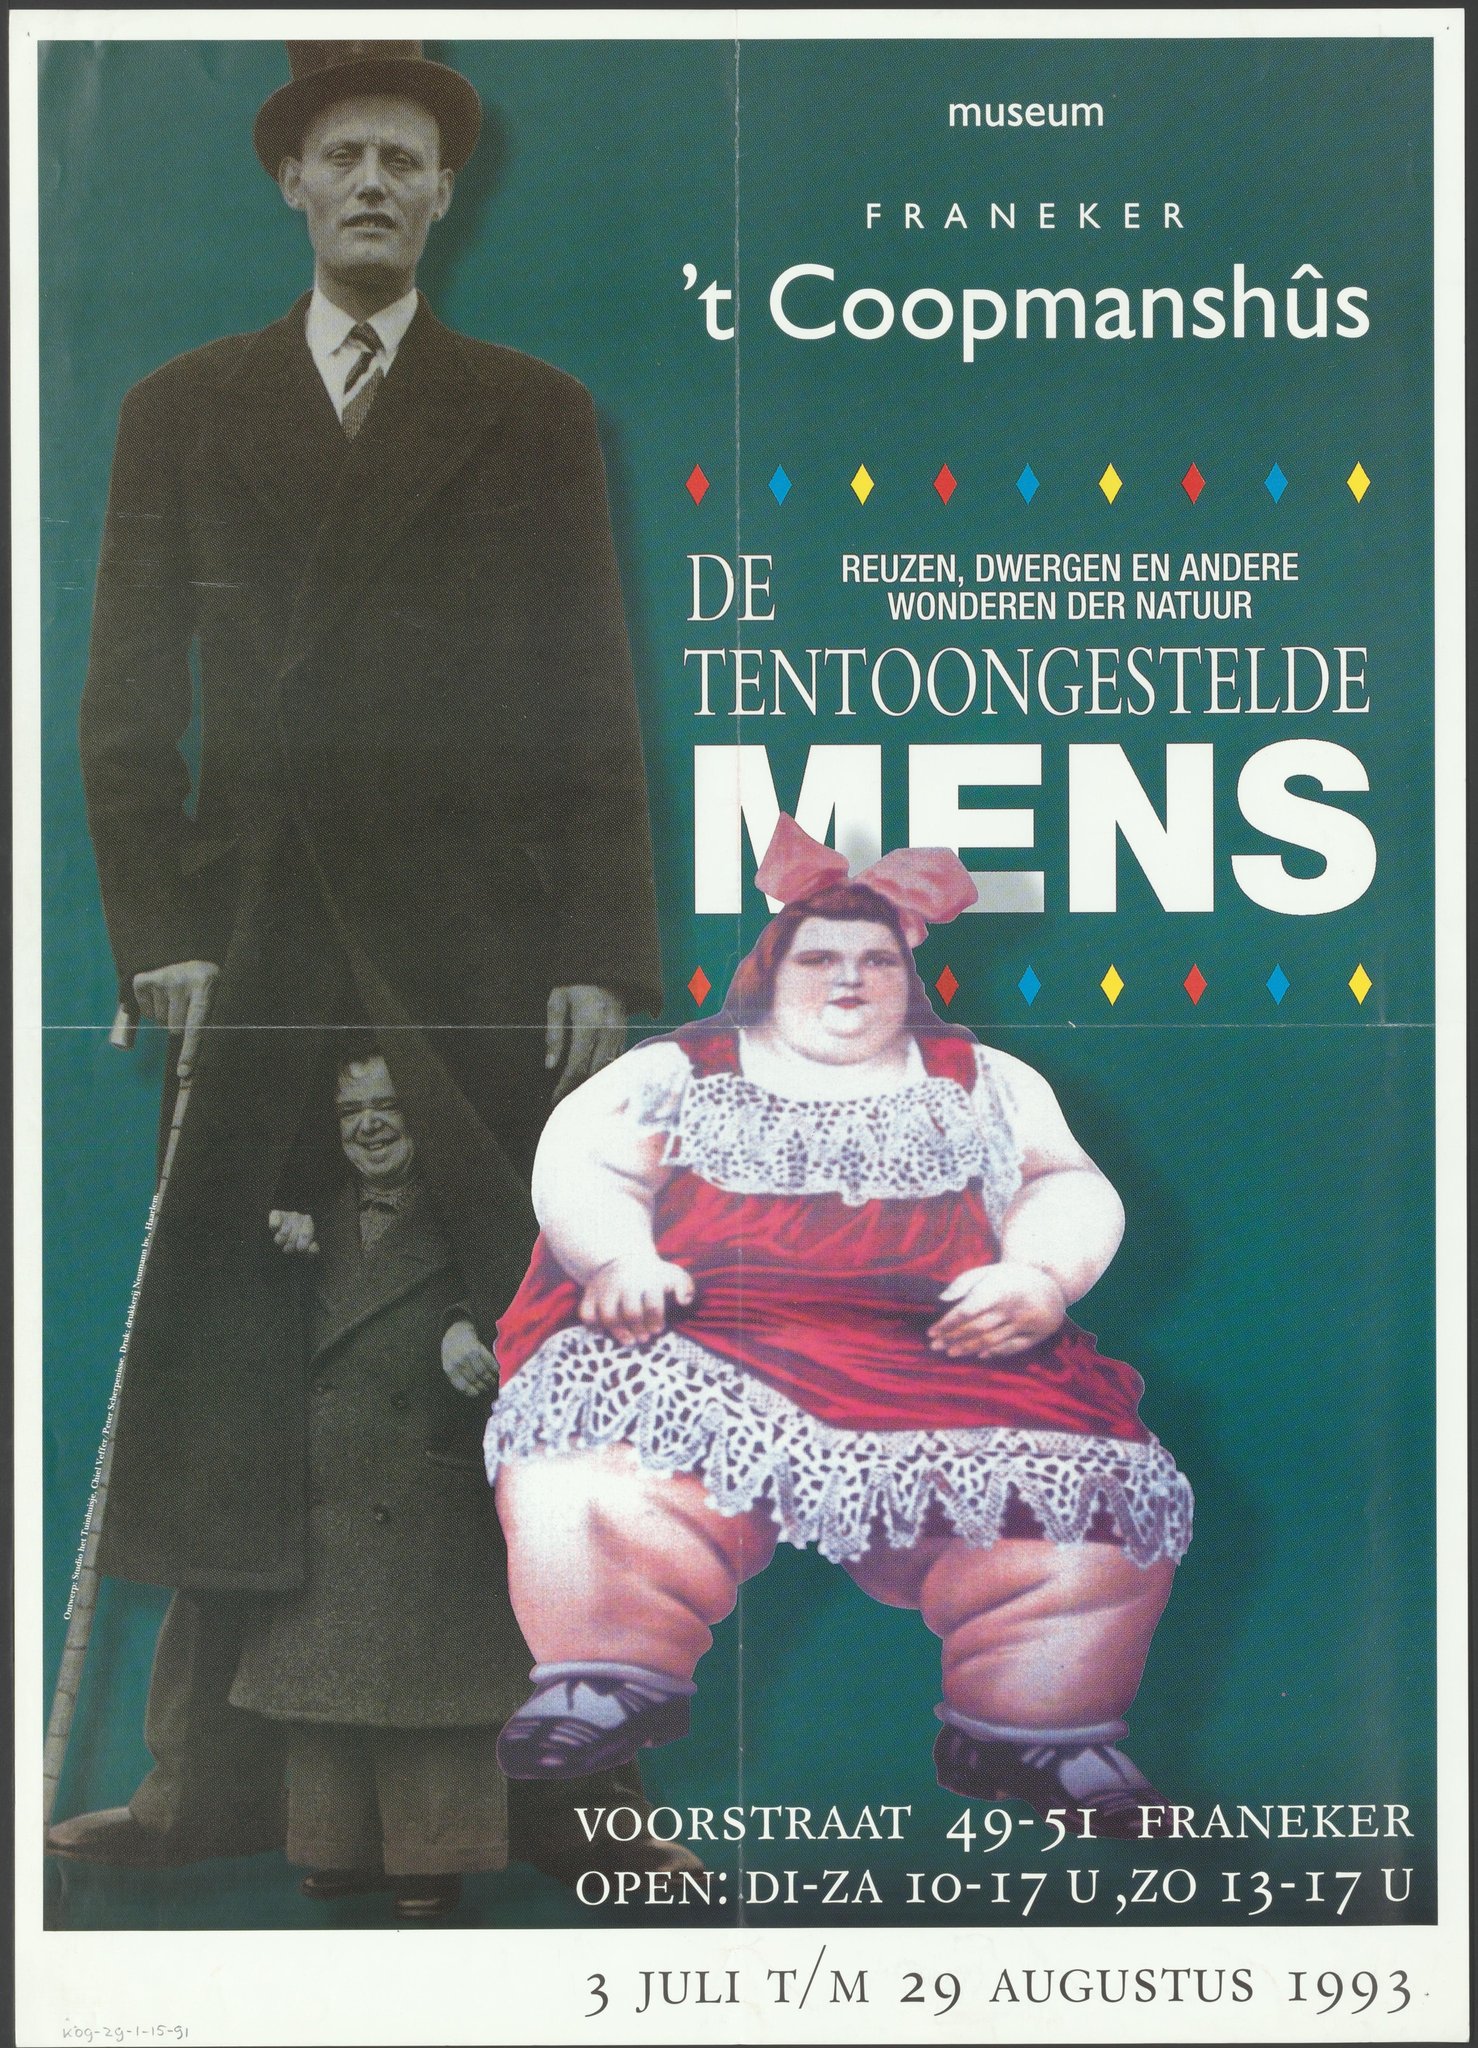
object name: poster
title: De Tentoongestelde Mens, reuzen, dwergen en andere wonderen der natuur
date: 1993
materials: paper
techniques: offset printed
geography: haarlem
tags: little people, collection, exhibition, show, giants, colossi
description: Affiche voor de tentoonstelling De Tentoongestelde Mens. Over reuzen, kleine mensen en andere wonderen der natuur. De tentoonstelling vond plaats in 't Coopmanshûs van museum Franeker tussen 3 juli en 29 augustus 1993. Onderwerpsrubrieken binnen de Atlas Zeden en Gewoonten: Handel, nijverheid en verkeer, Tentoonstellingen.